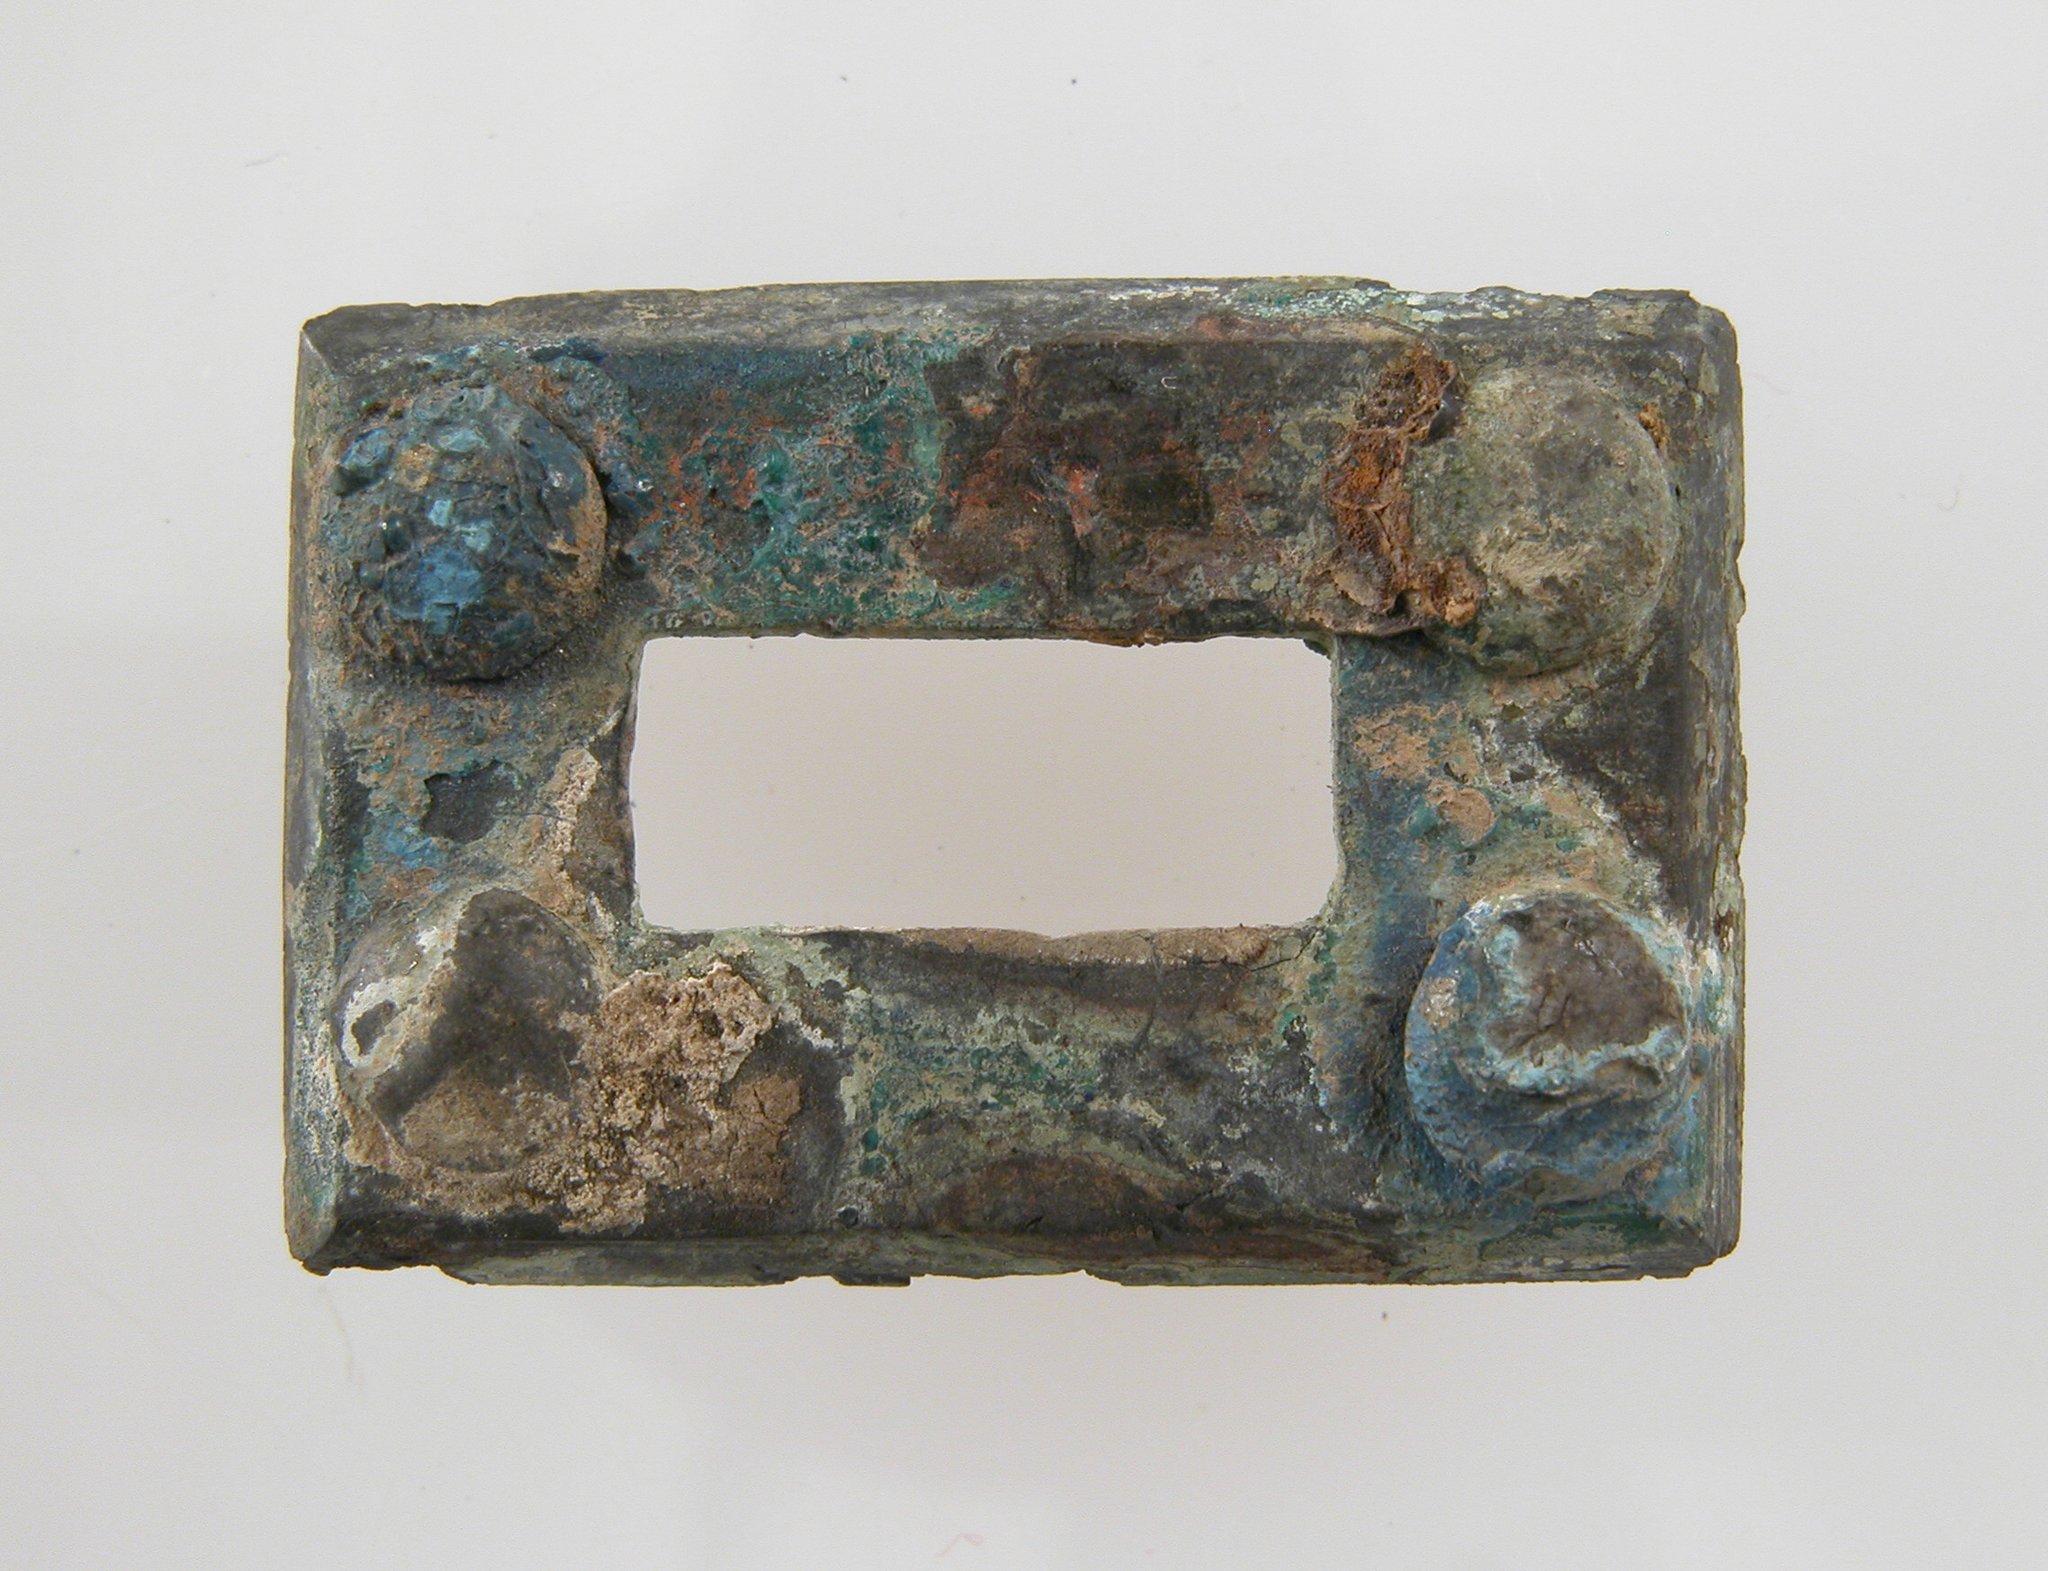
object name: plaque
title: Rectangular Plaque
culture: frankish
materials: copper alloy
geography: germany